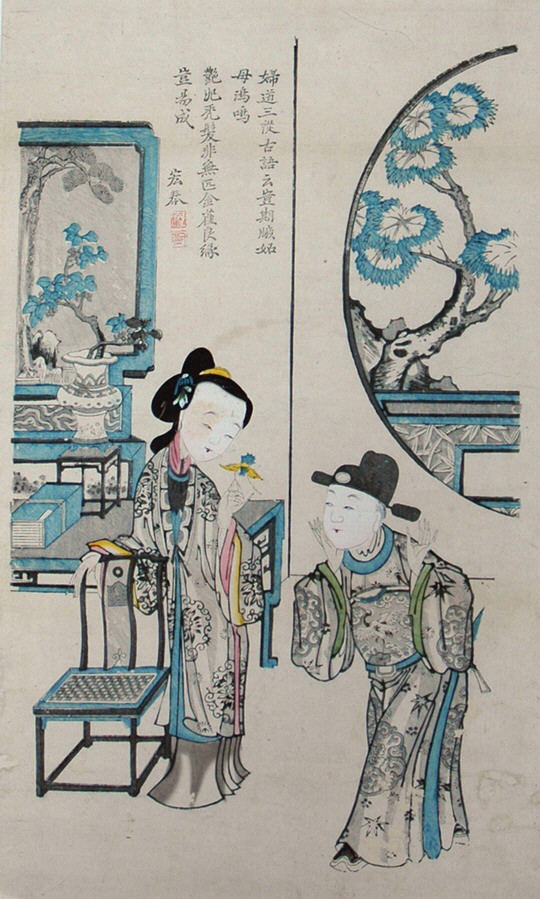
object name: print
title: A Happy Marriage Symbolized by the Golden Sparrow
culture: chinese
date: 1801-1900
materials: ink, paper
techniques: polychrome, woodblock print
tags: women,trees,chairs